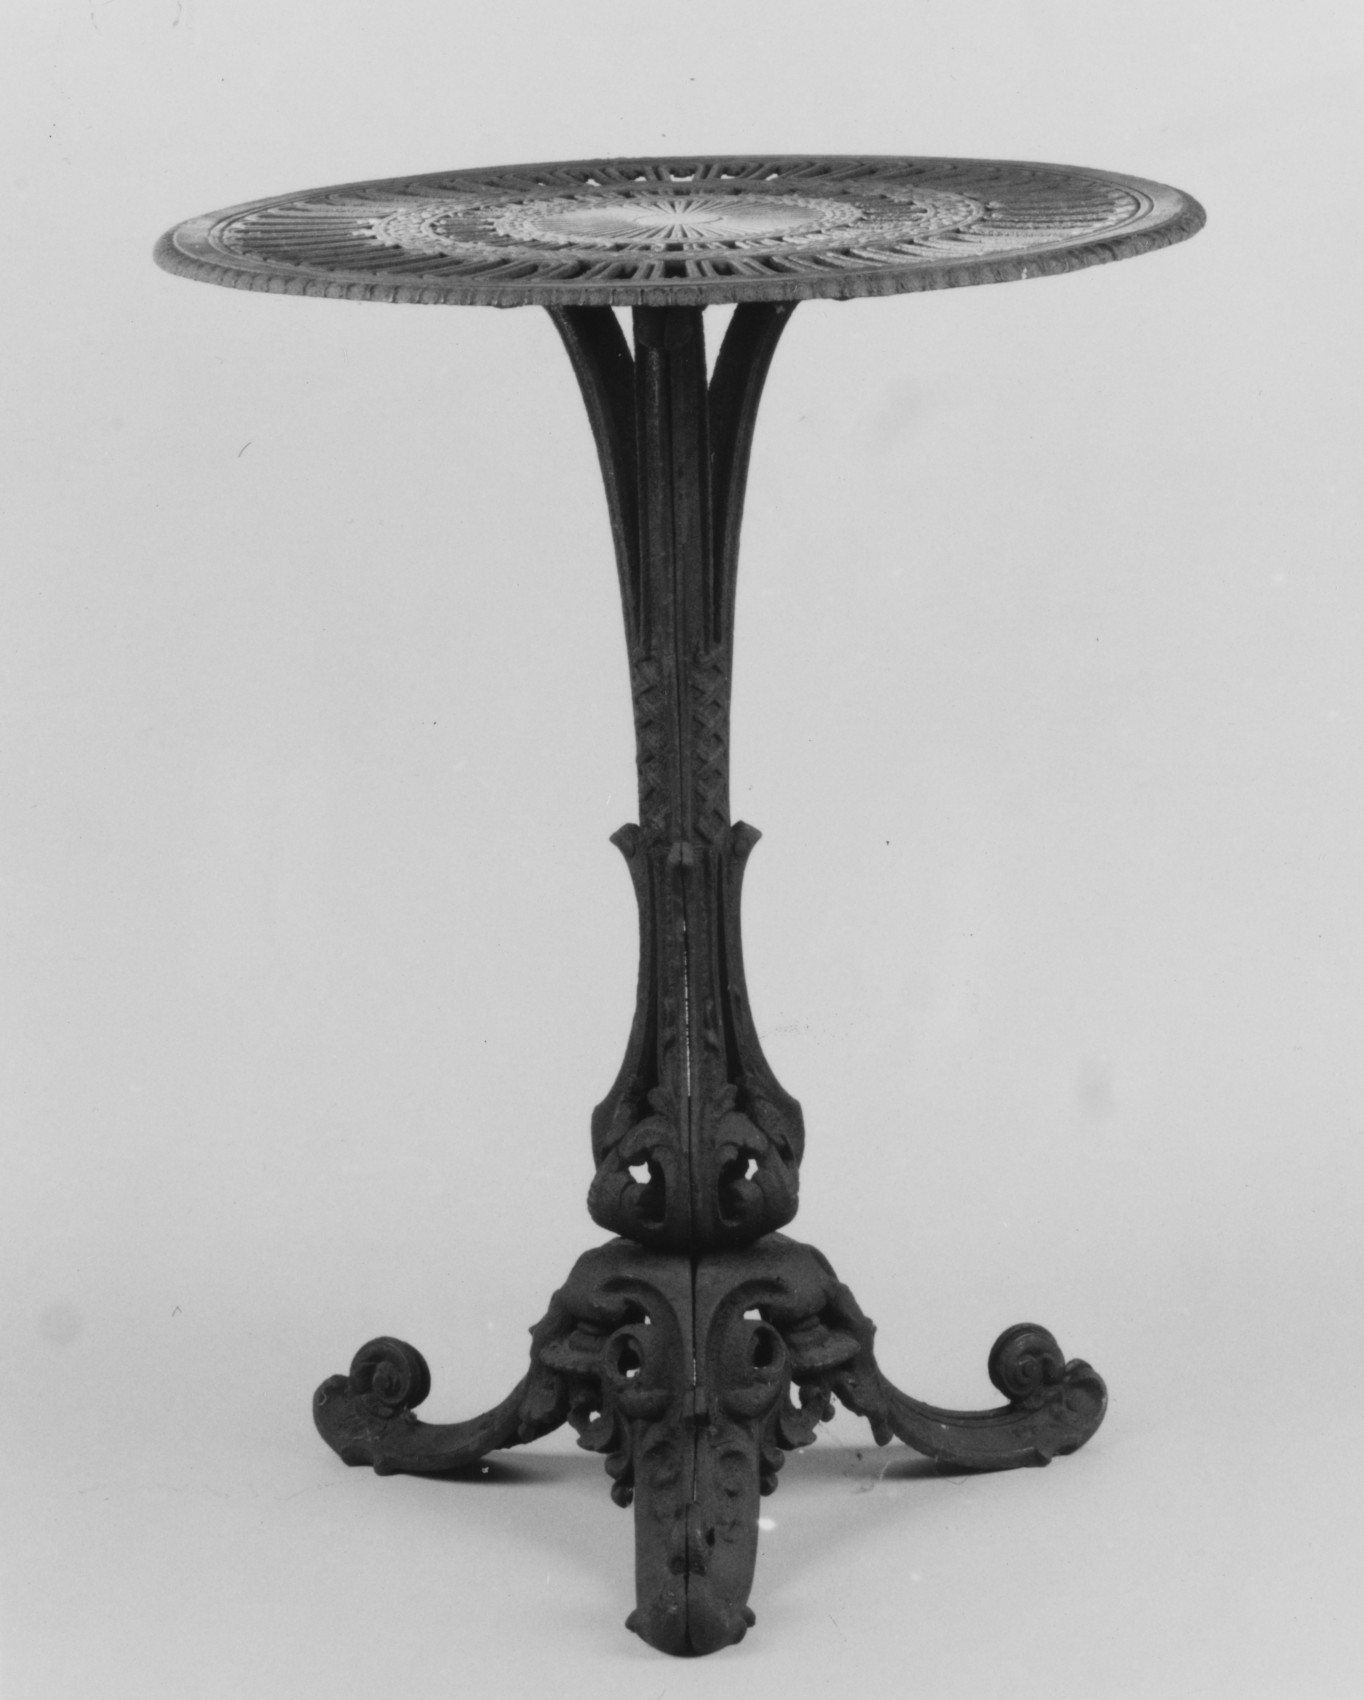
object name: garden table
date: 1860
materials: iron